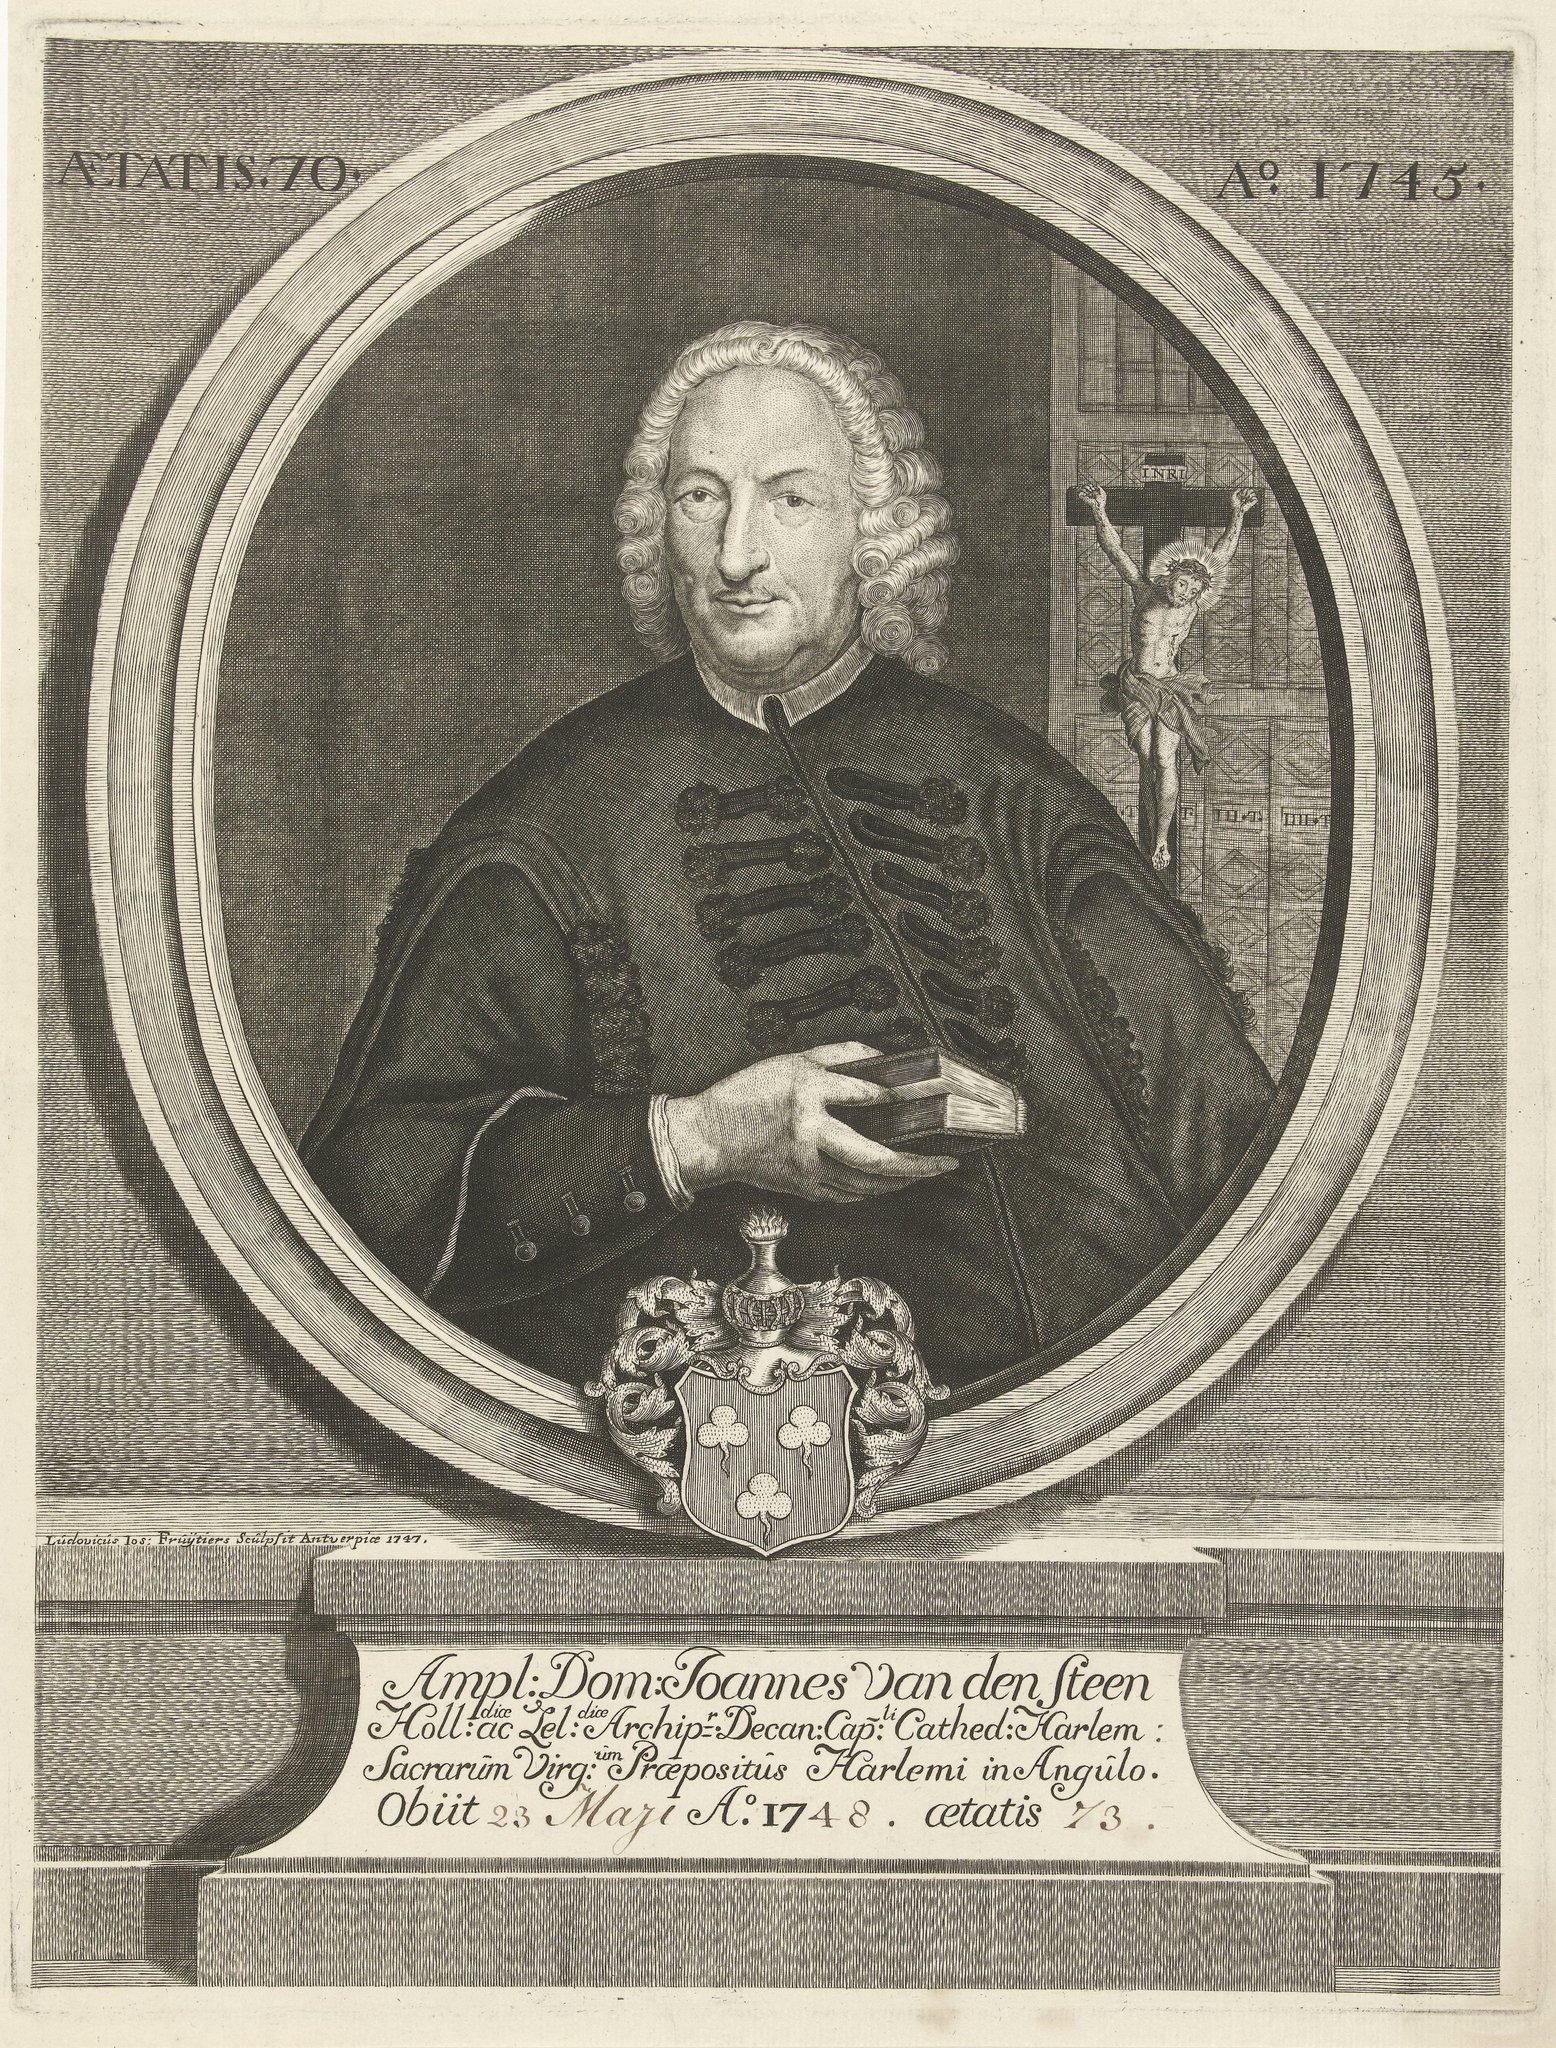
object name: print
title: Portret van Joannes van den Steen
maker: lodewijk joseph fruytiers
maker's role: print maker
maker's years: 1713-1782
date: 1747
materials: paper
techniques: engraving, etching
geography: antwerp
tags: joannes van den steen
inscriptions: date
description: Portret ten halven lijve in ovaal van aartspriester en pastoor Joannes van den Steen. In zijn rechterhand houdt hij een toegeslagen gebedenboek vast, rechts achter hem staat een boekenkast waar het kruisbeeld voor hangt. Bovenin is links en rechts van de ovale lijst vermeld: Aetatis. 70 - Ao 1745, onderin de lijst is het wapenschild van de geportretteerde afgebeeld. Het portret staat op een sokkel waarop een vierregelige tekst in het Latijn. Zijn sterfdatum is met bruine inkt ingevuld.